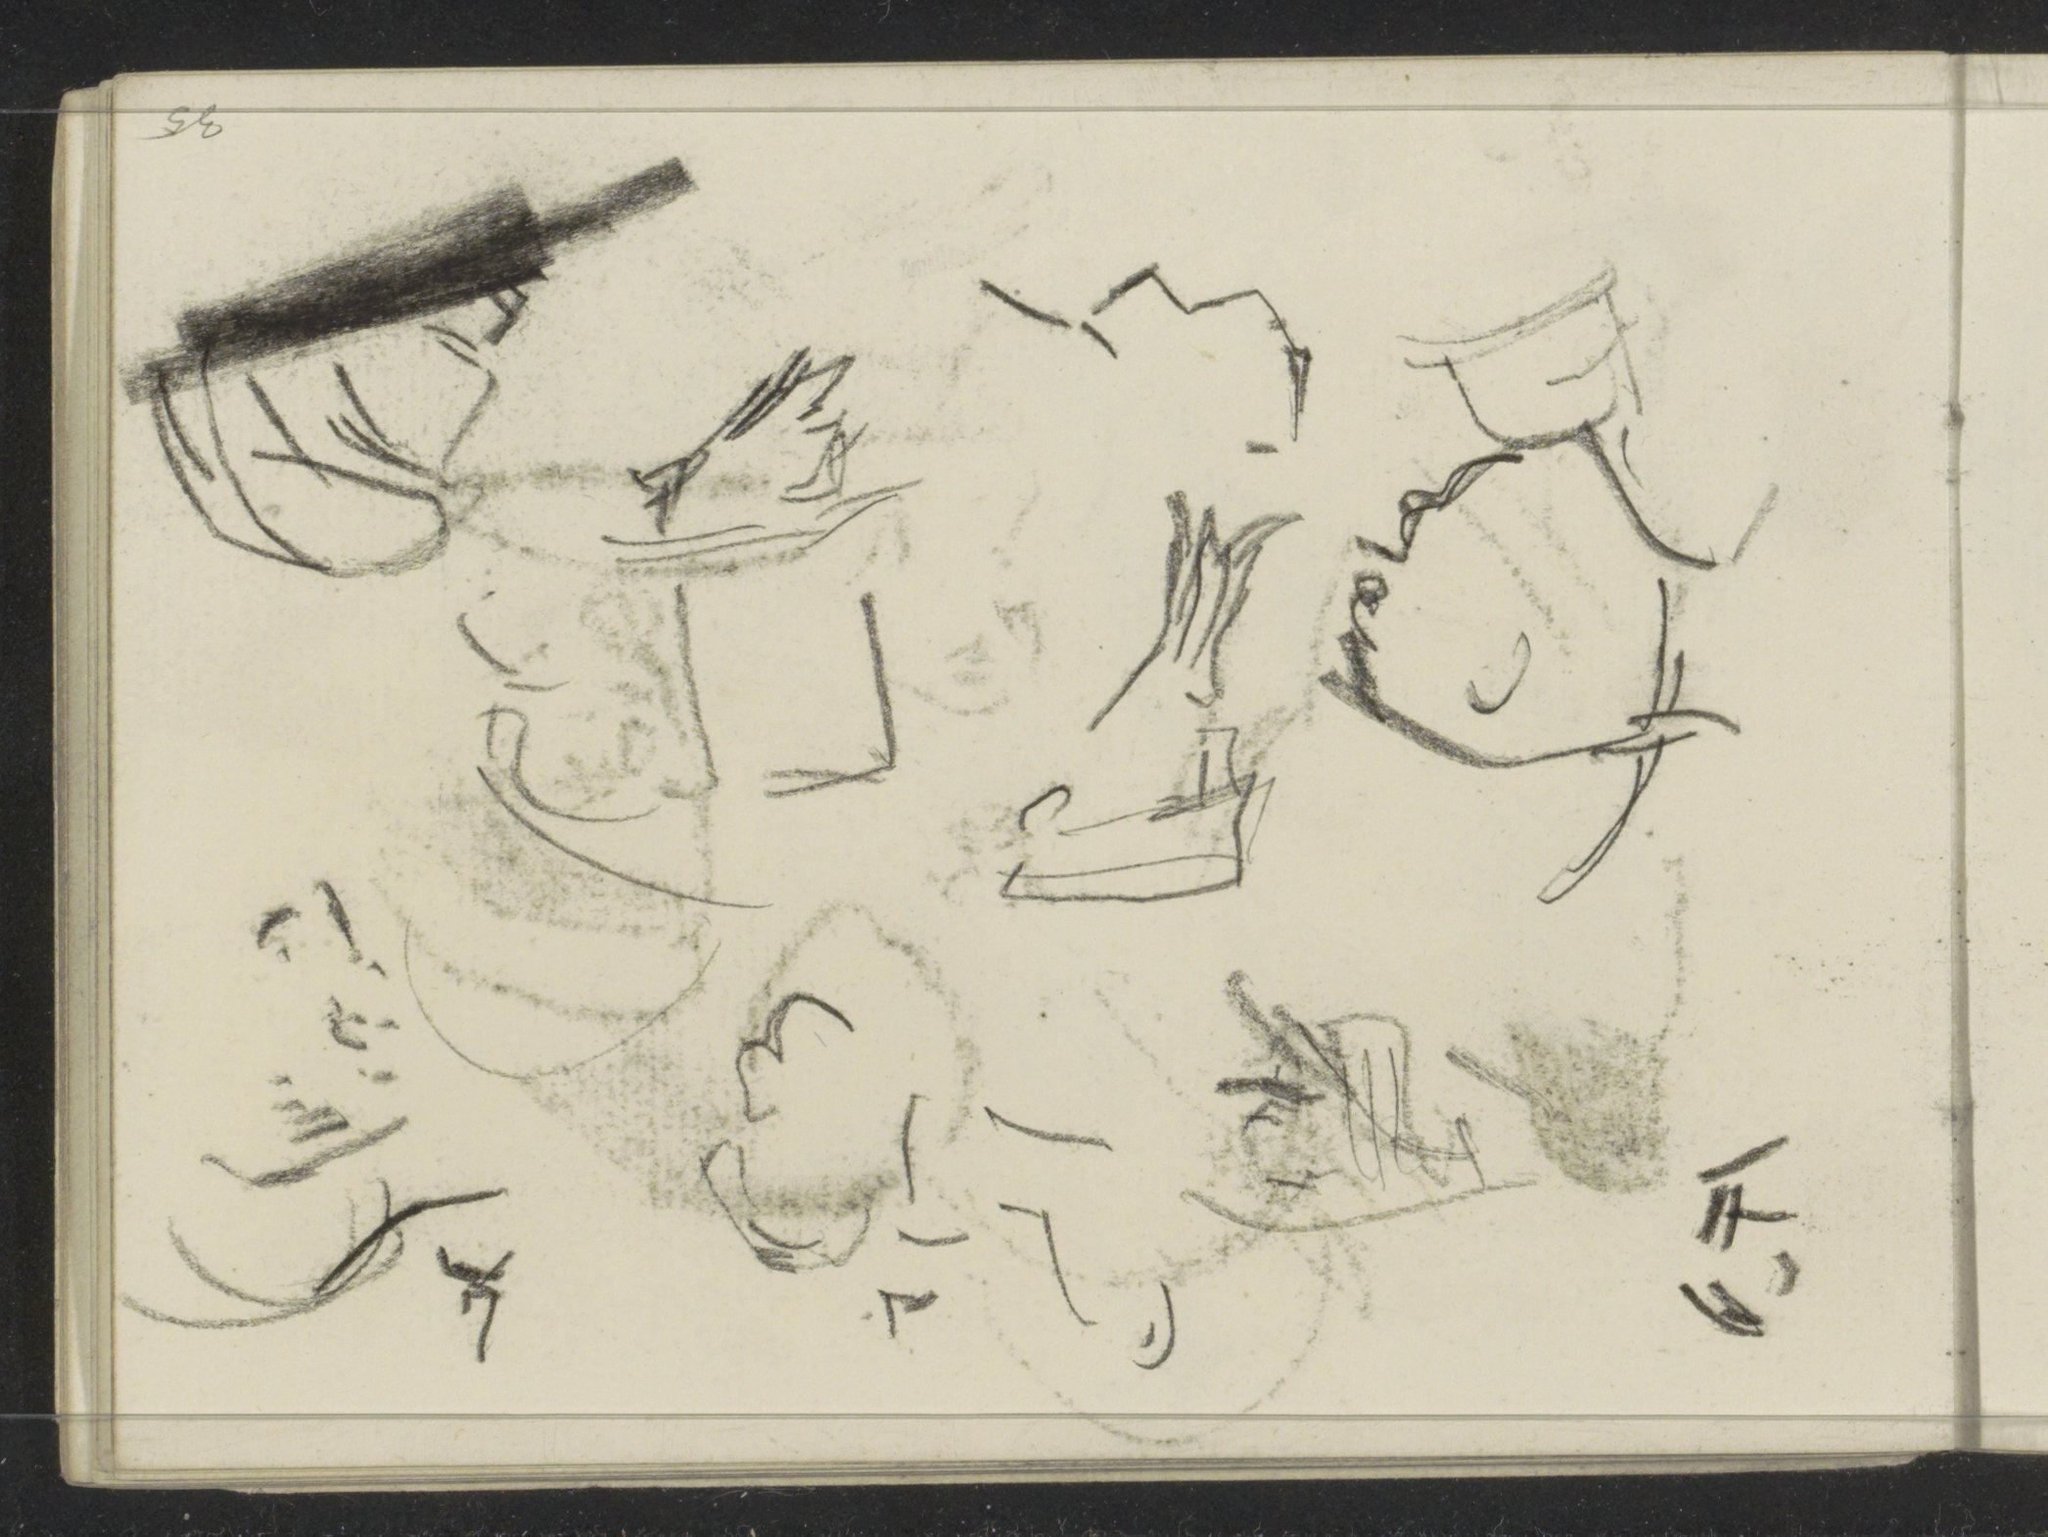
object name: sketchbook leaf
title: Hoofden met verschillende hoeden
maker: isaac israels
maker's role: draughtsman, painter, print maker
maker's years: 1865-1934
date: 1886-1934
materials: chalk, paper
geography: amsterdam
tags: head (human), head-gear: hat, head (human) - aa - female human figure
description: Blad 24 verso uit schetsboek LXIV met 29 bladen.